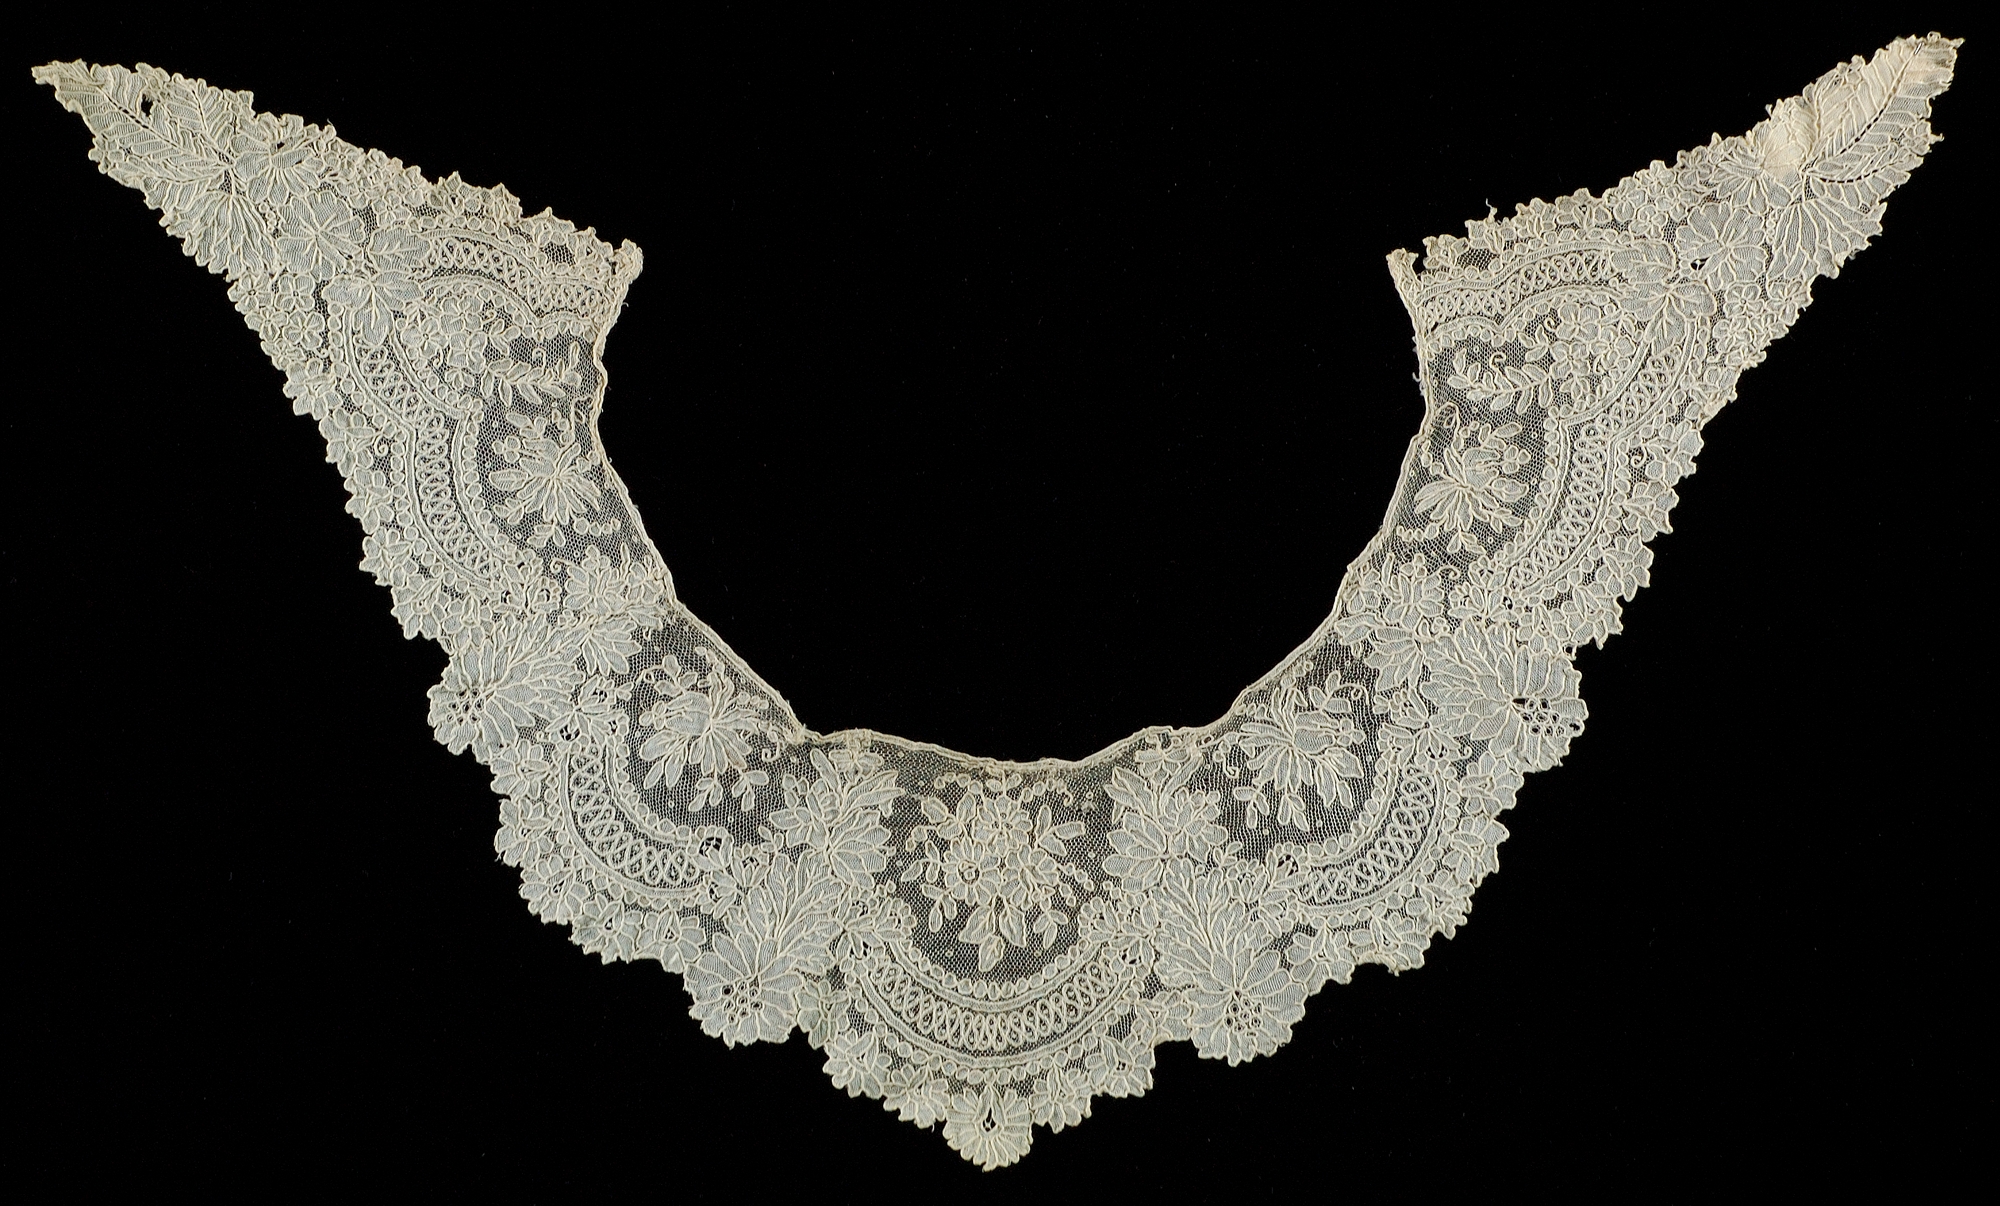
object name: collar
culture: belgian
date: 1860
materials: linen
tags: flowers